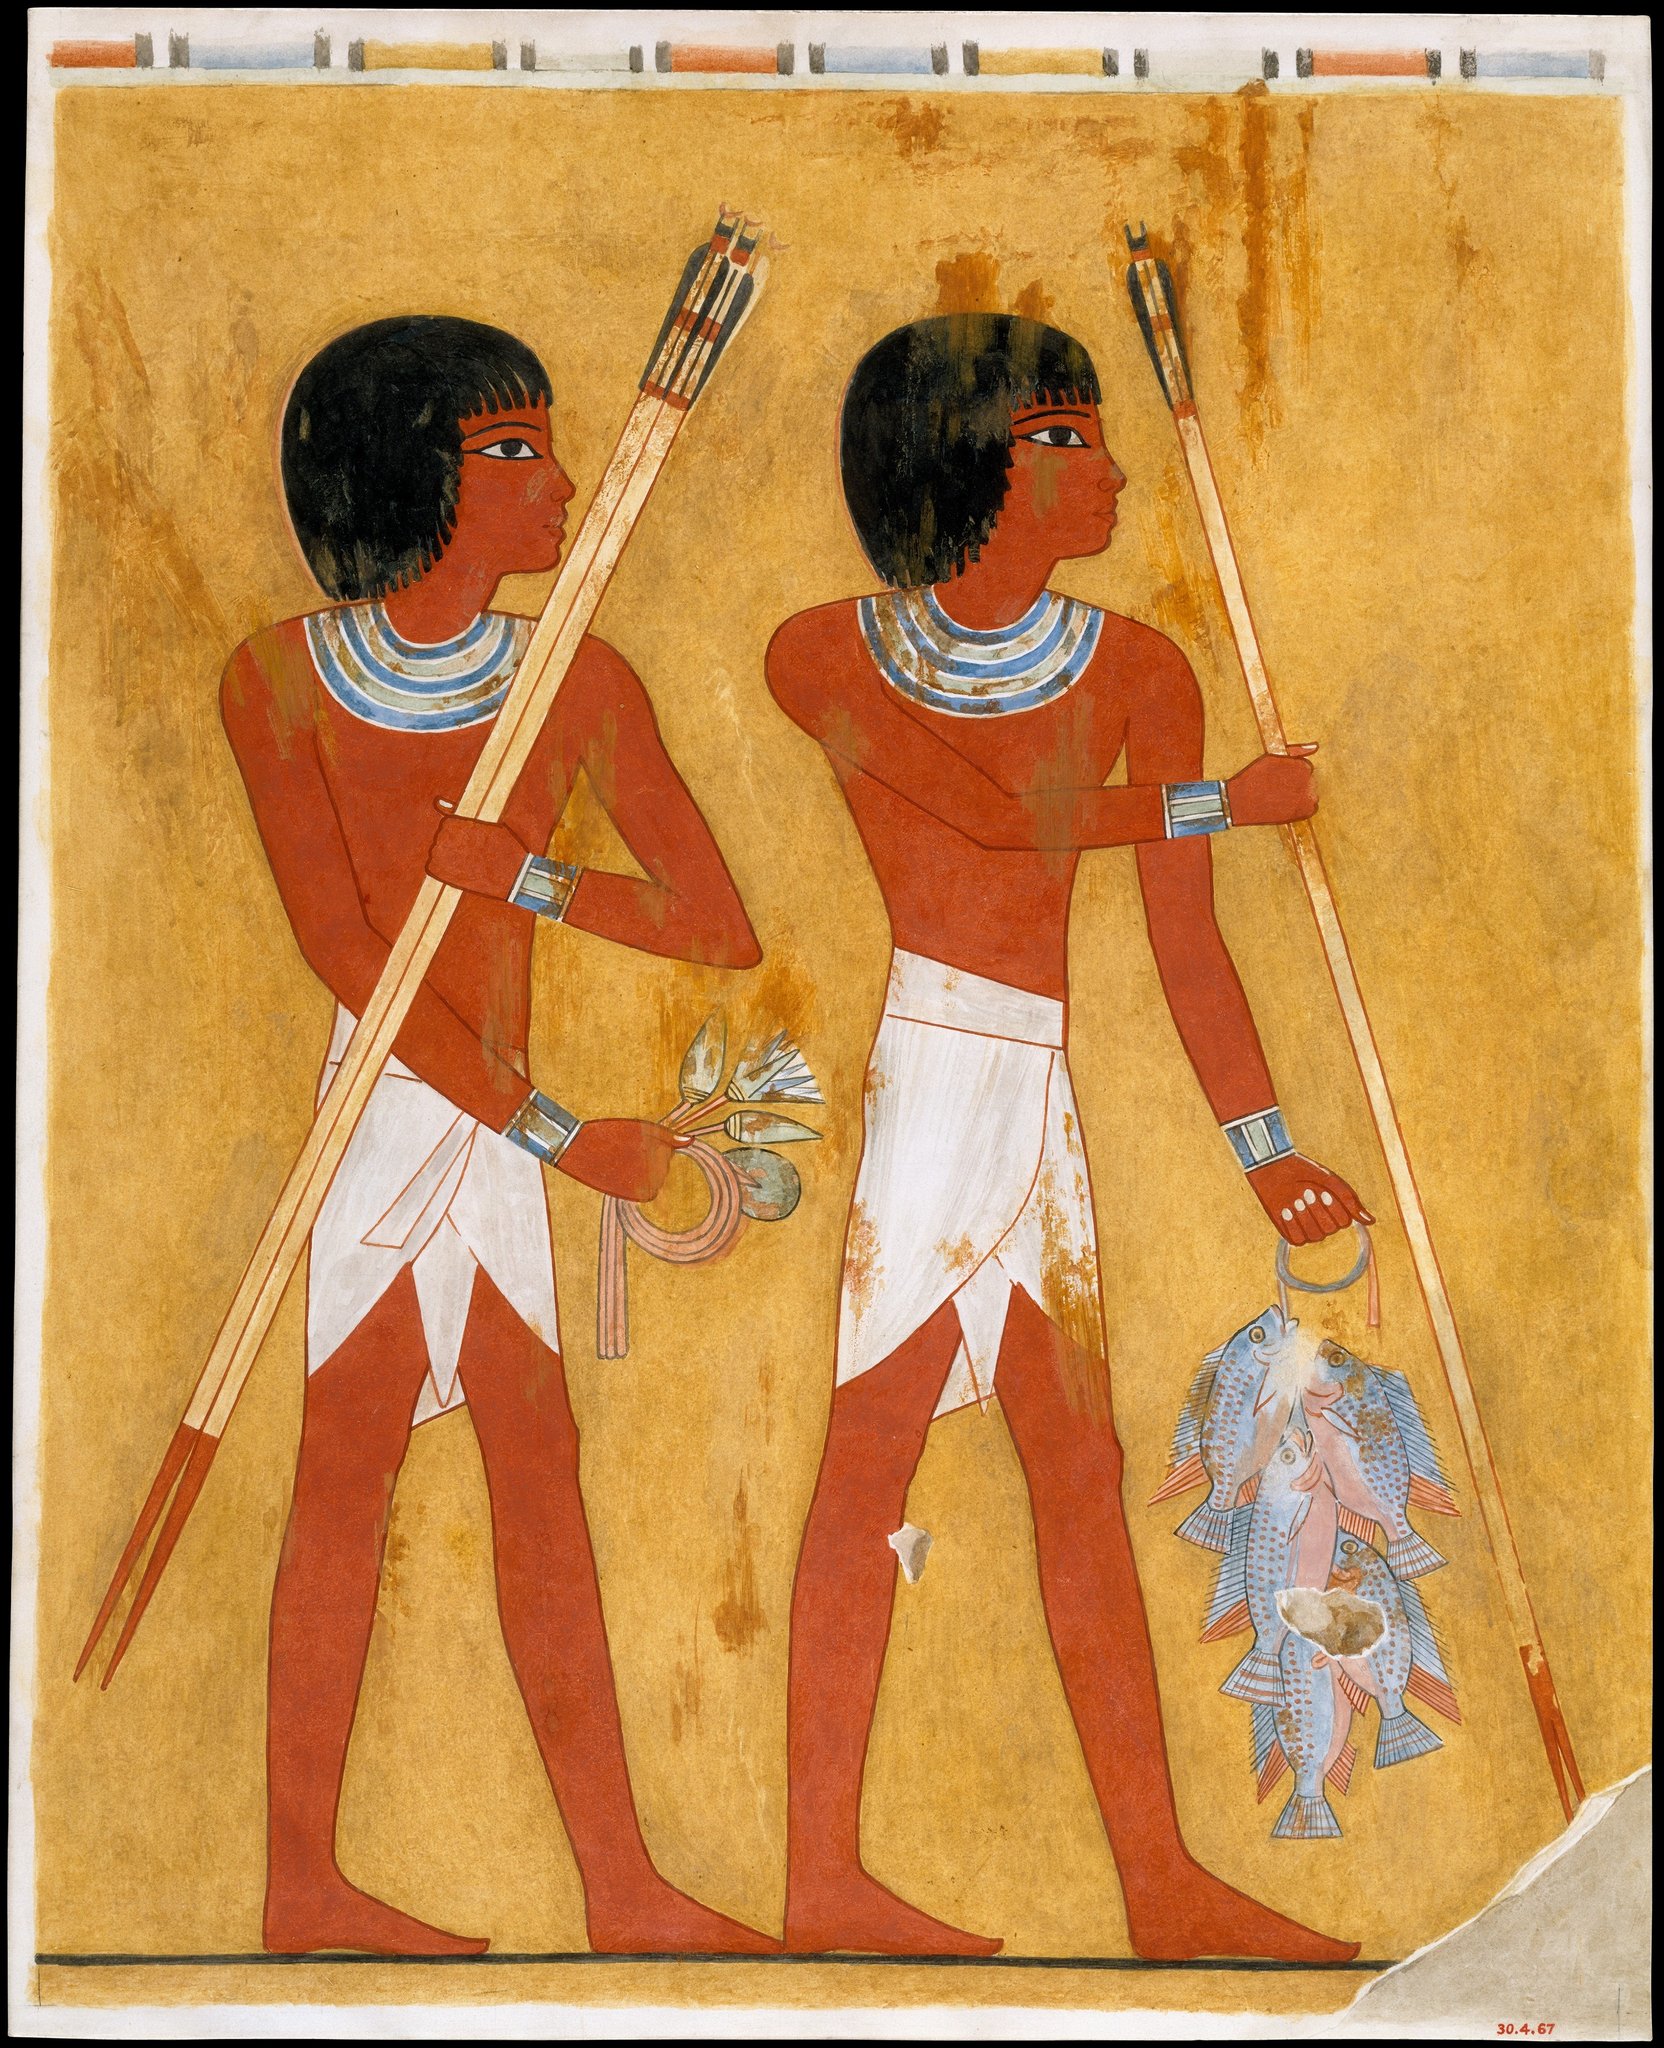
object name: facsimile, qenamun tt 93, fishing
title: Detail from a Fishing Scene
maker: hugh r. hopgood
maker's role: artist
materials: paper, paint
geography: egypt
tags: men,fishing,fish